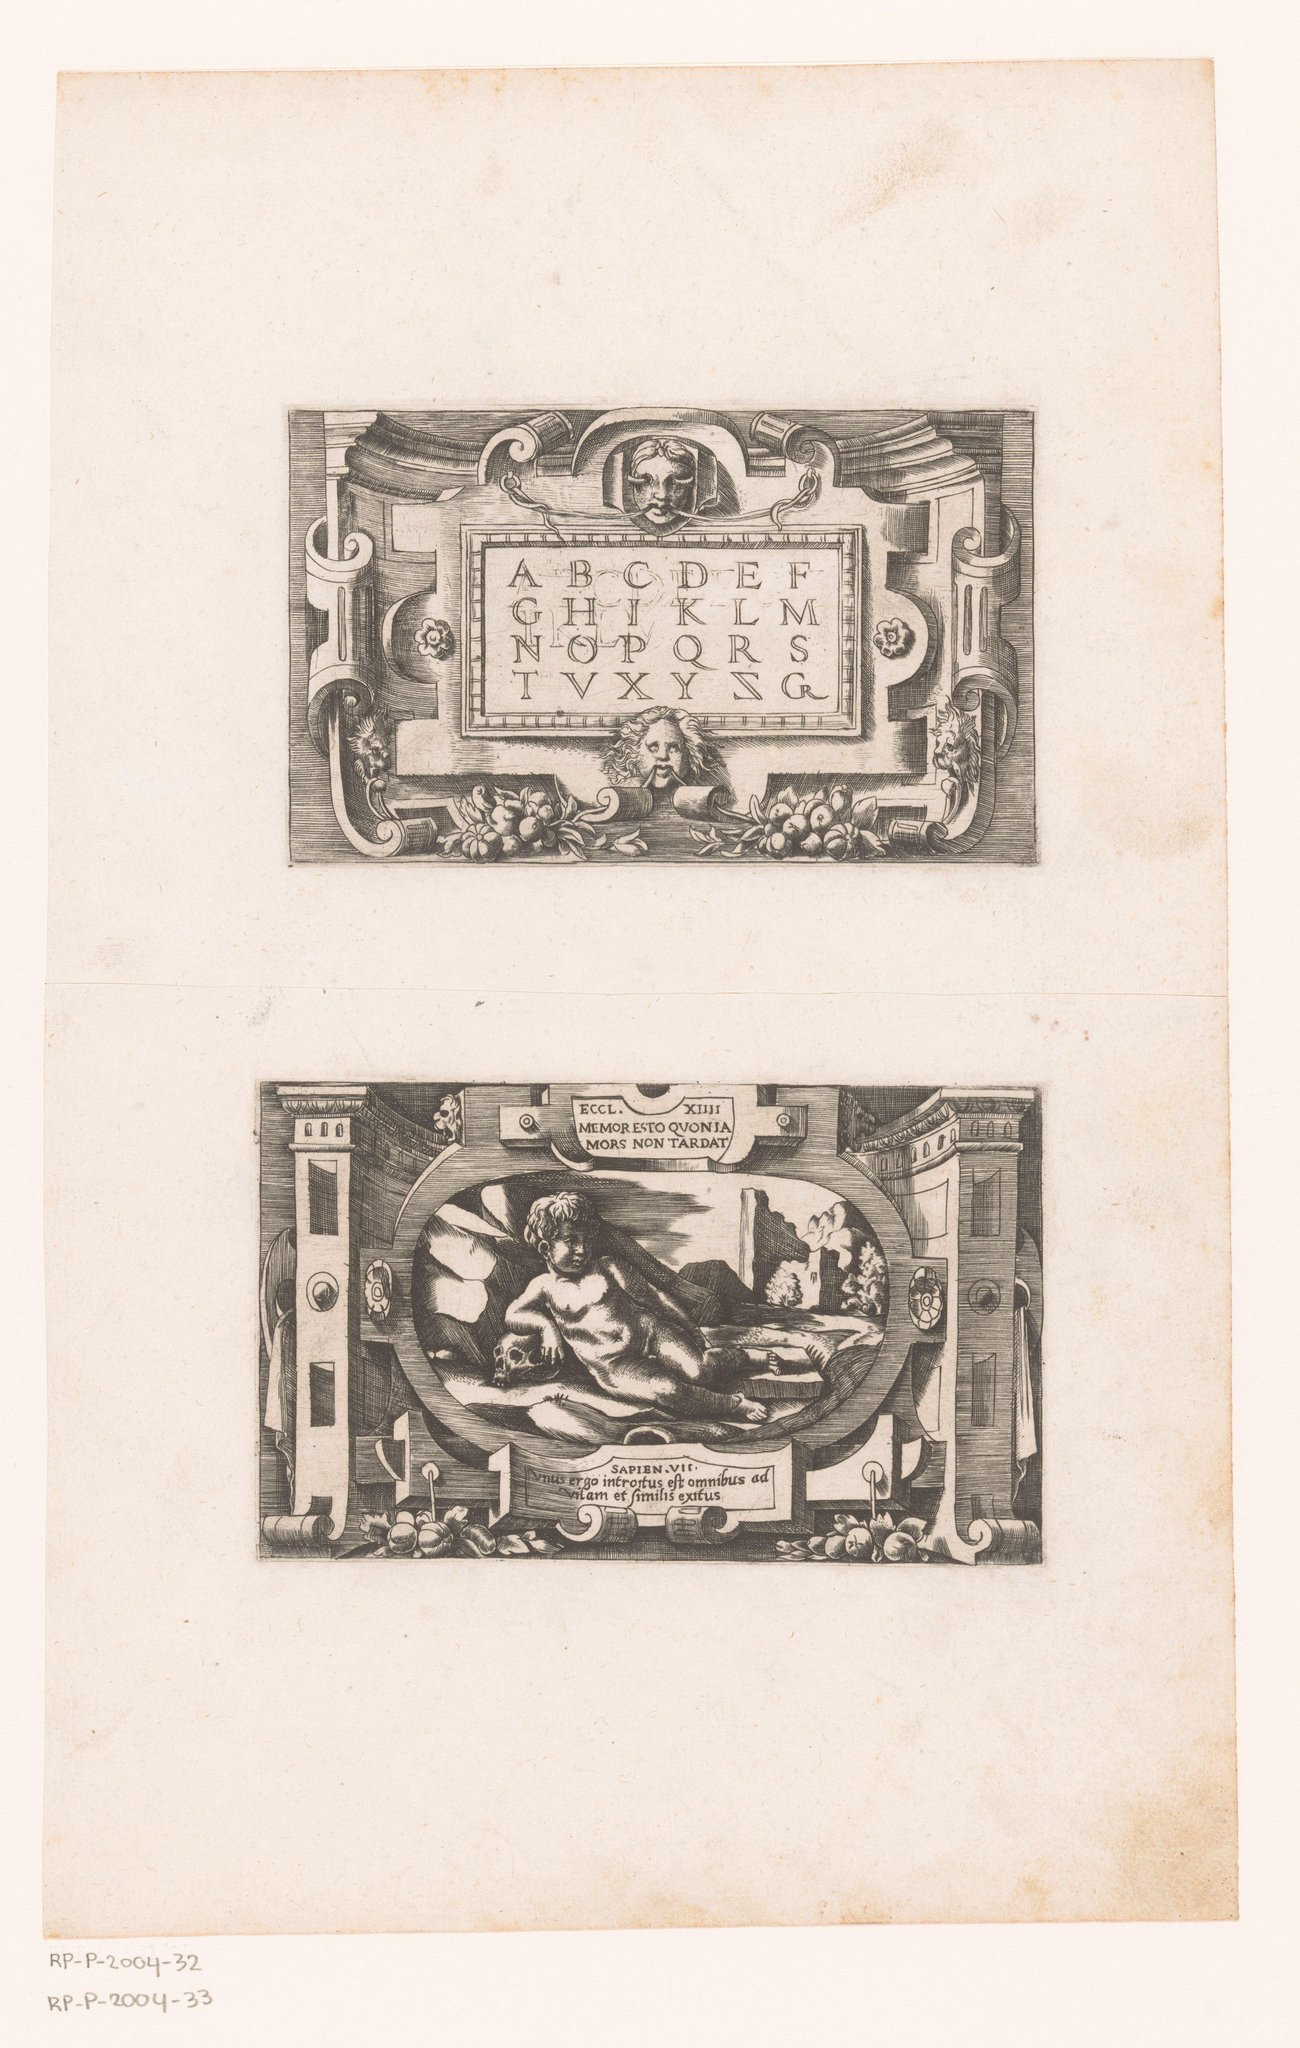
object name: print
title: Cartouches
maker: georges reverdy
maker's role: print maker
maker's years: 1450-1565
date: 1536-1569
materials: paper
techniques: engraving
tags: 'vanitas' symbols, ornament ~ cartouche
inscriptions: collector's mark: Lugt 2760, collector's mark: Lugt 2228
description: Prent maakt deel uit van een ongenummerde serie van drie prenten.